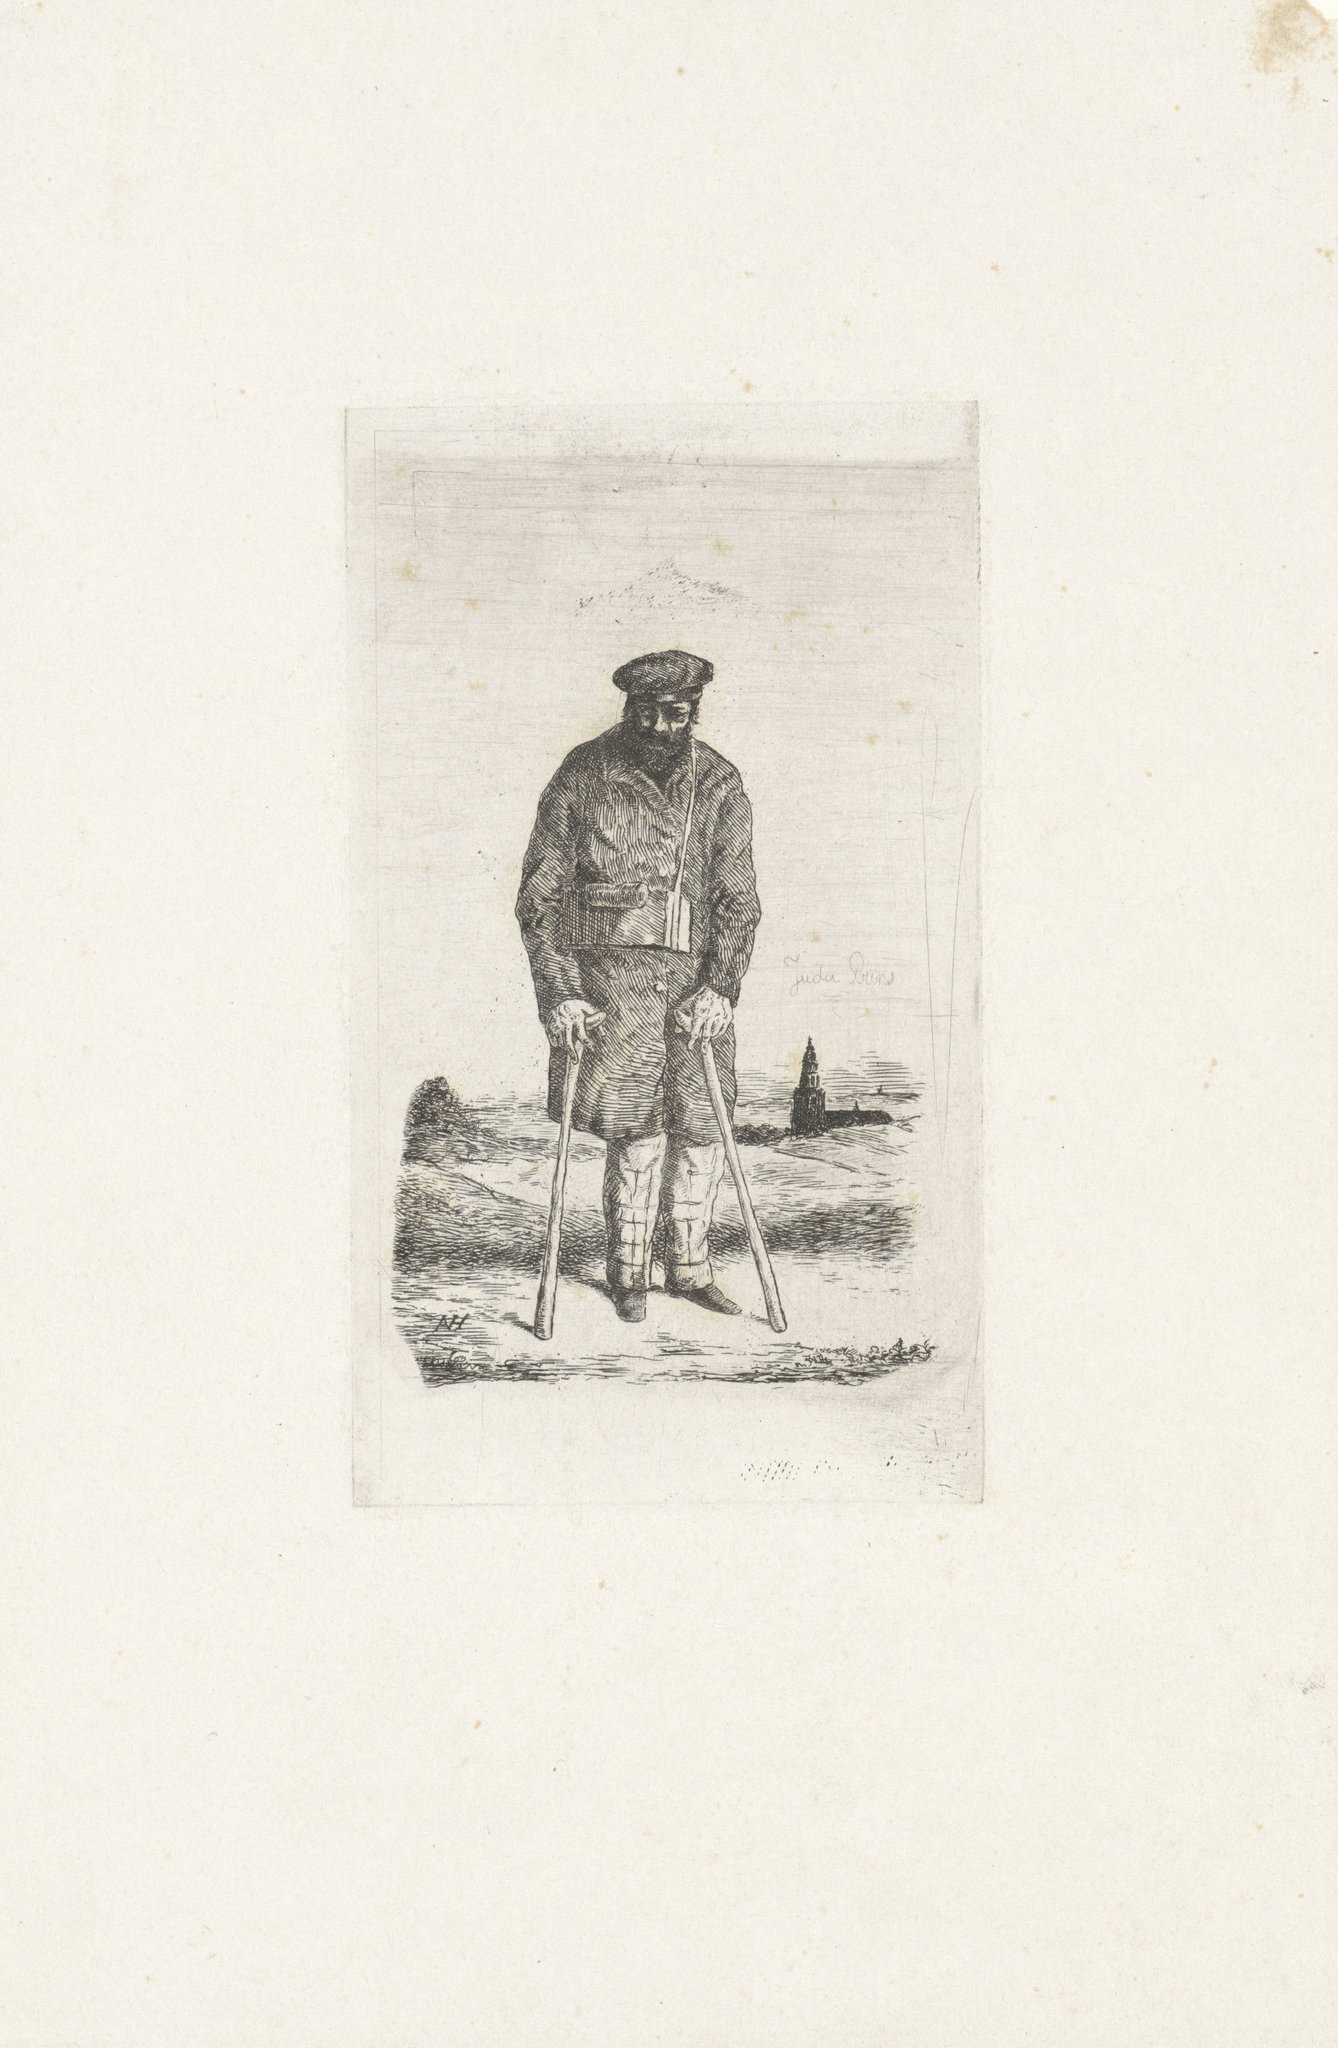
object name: print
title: Man op krukken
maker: alexander ver huell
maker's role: draughtsman, print maker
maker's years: 1822-1897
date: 1832-1897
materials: paper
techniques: etching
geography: netherlands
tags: crutches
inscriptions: collector's mark: Lugt 2228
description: Een man op krukken in een landschap met op de achtergrond een kerk.